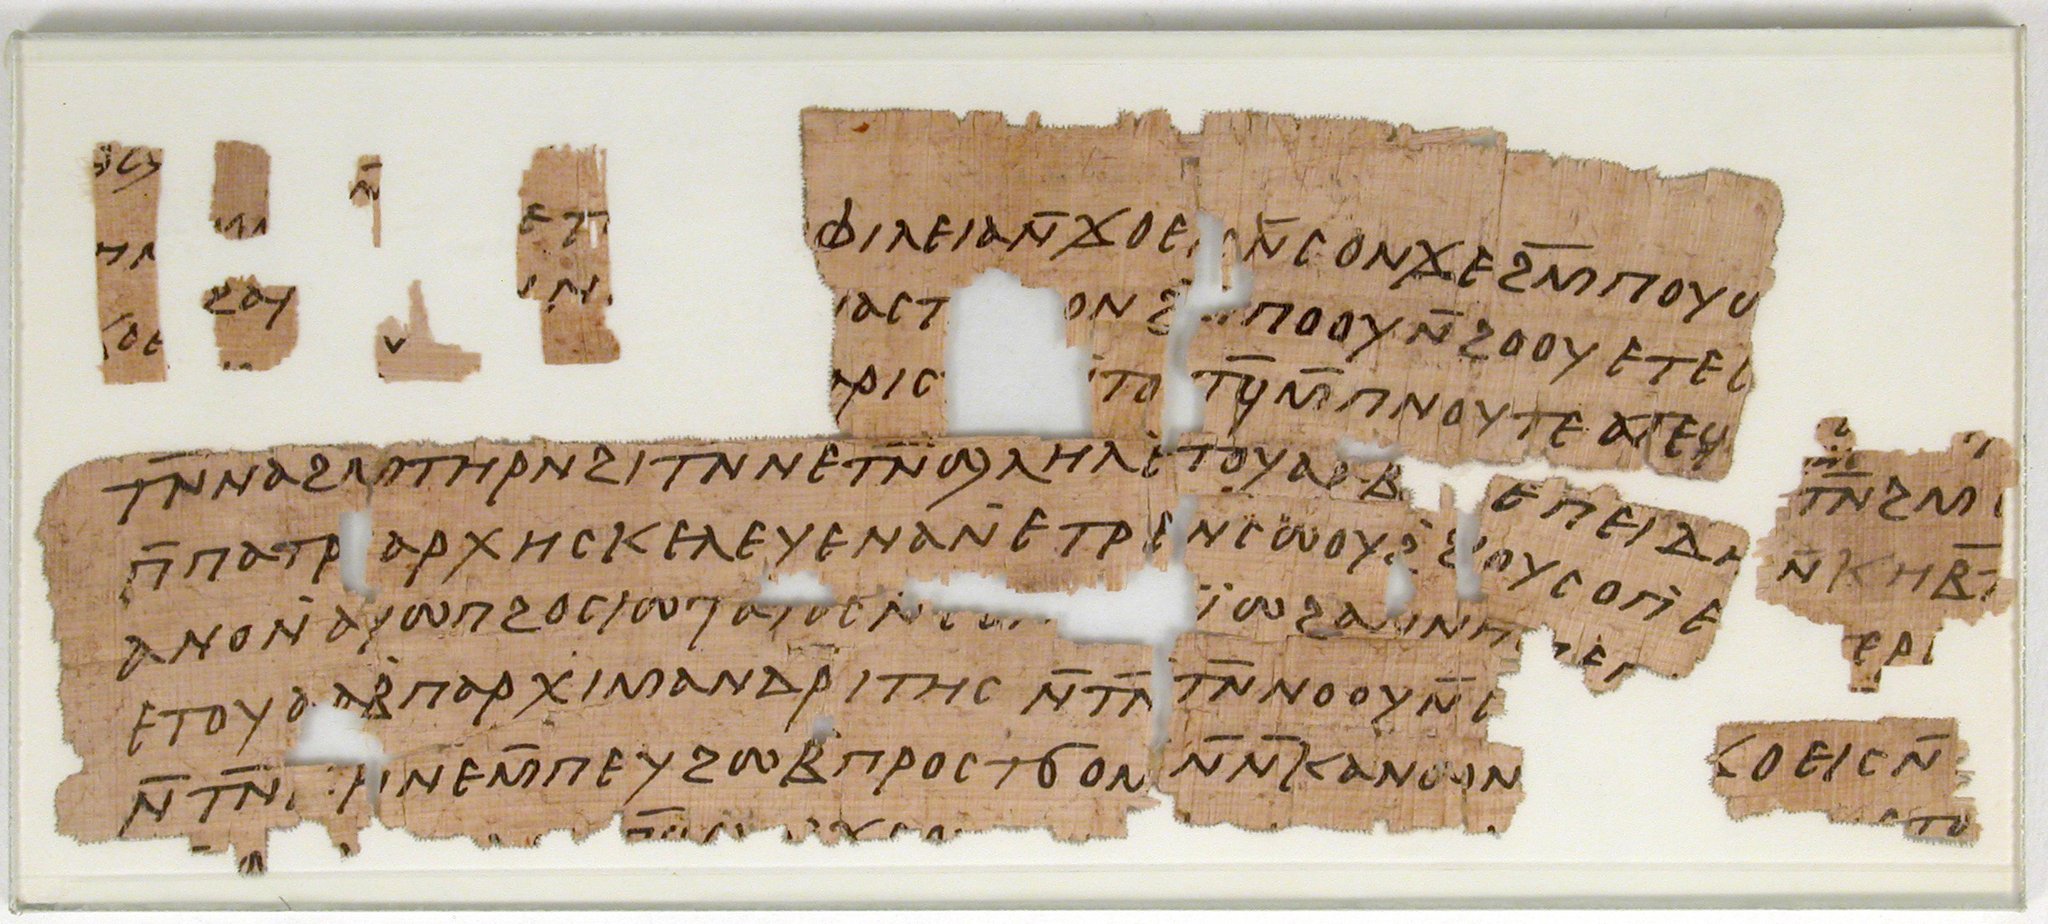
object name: fragment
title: Papyrus Fragments of a Letter from John and Pesenthius to Epiphanius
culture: coptic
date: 580-640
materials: ink, papyrus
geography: egypt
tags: coptic,documents